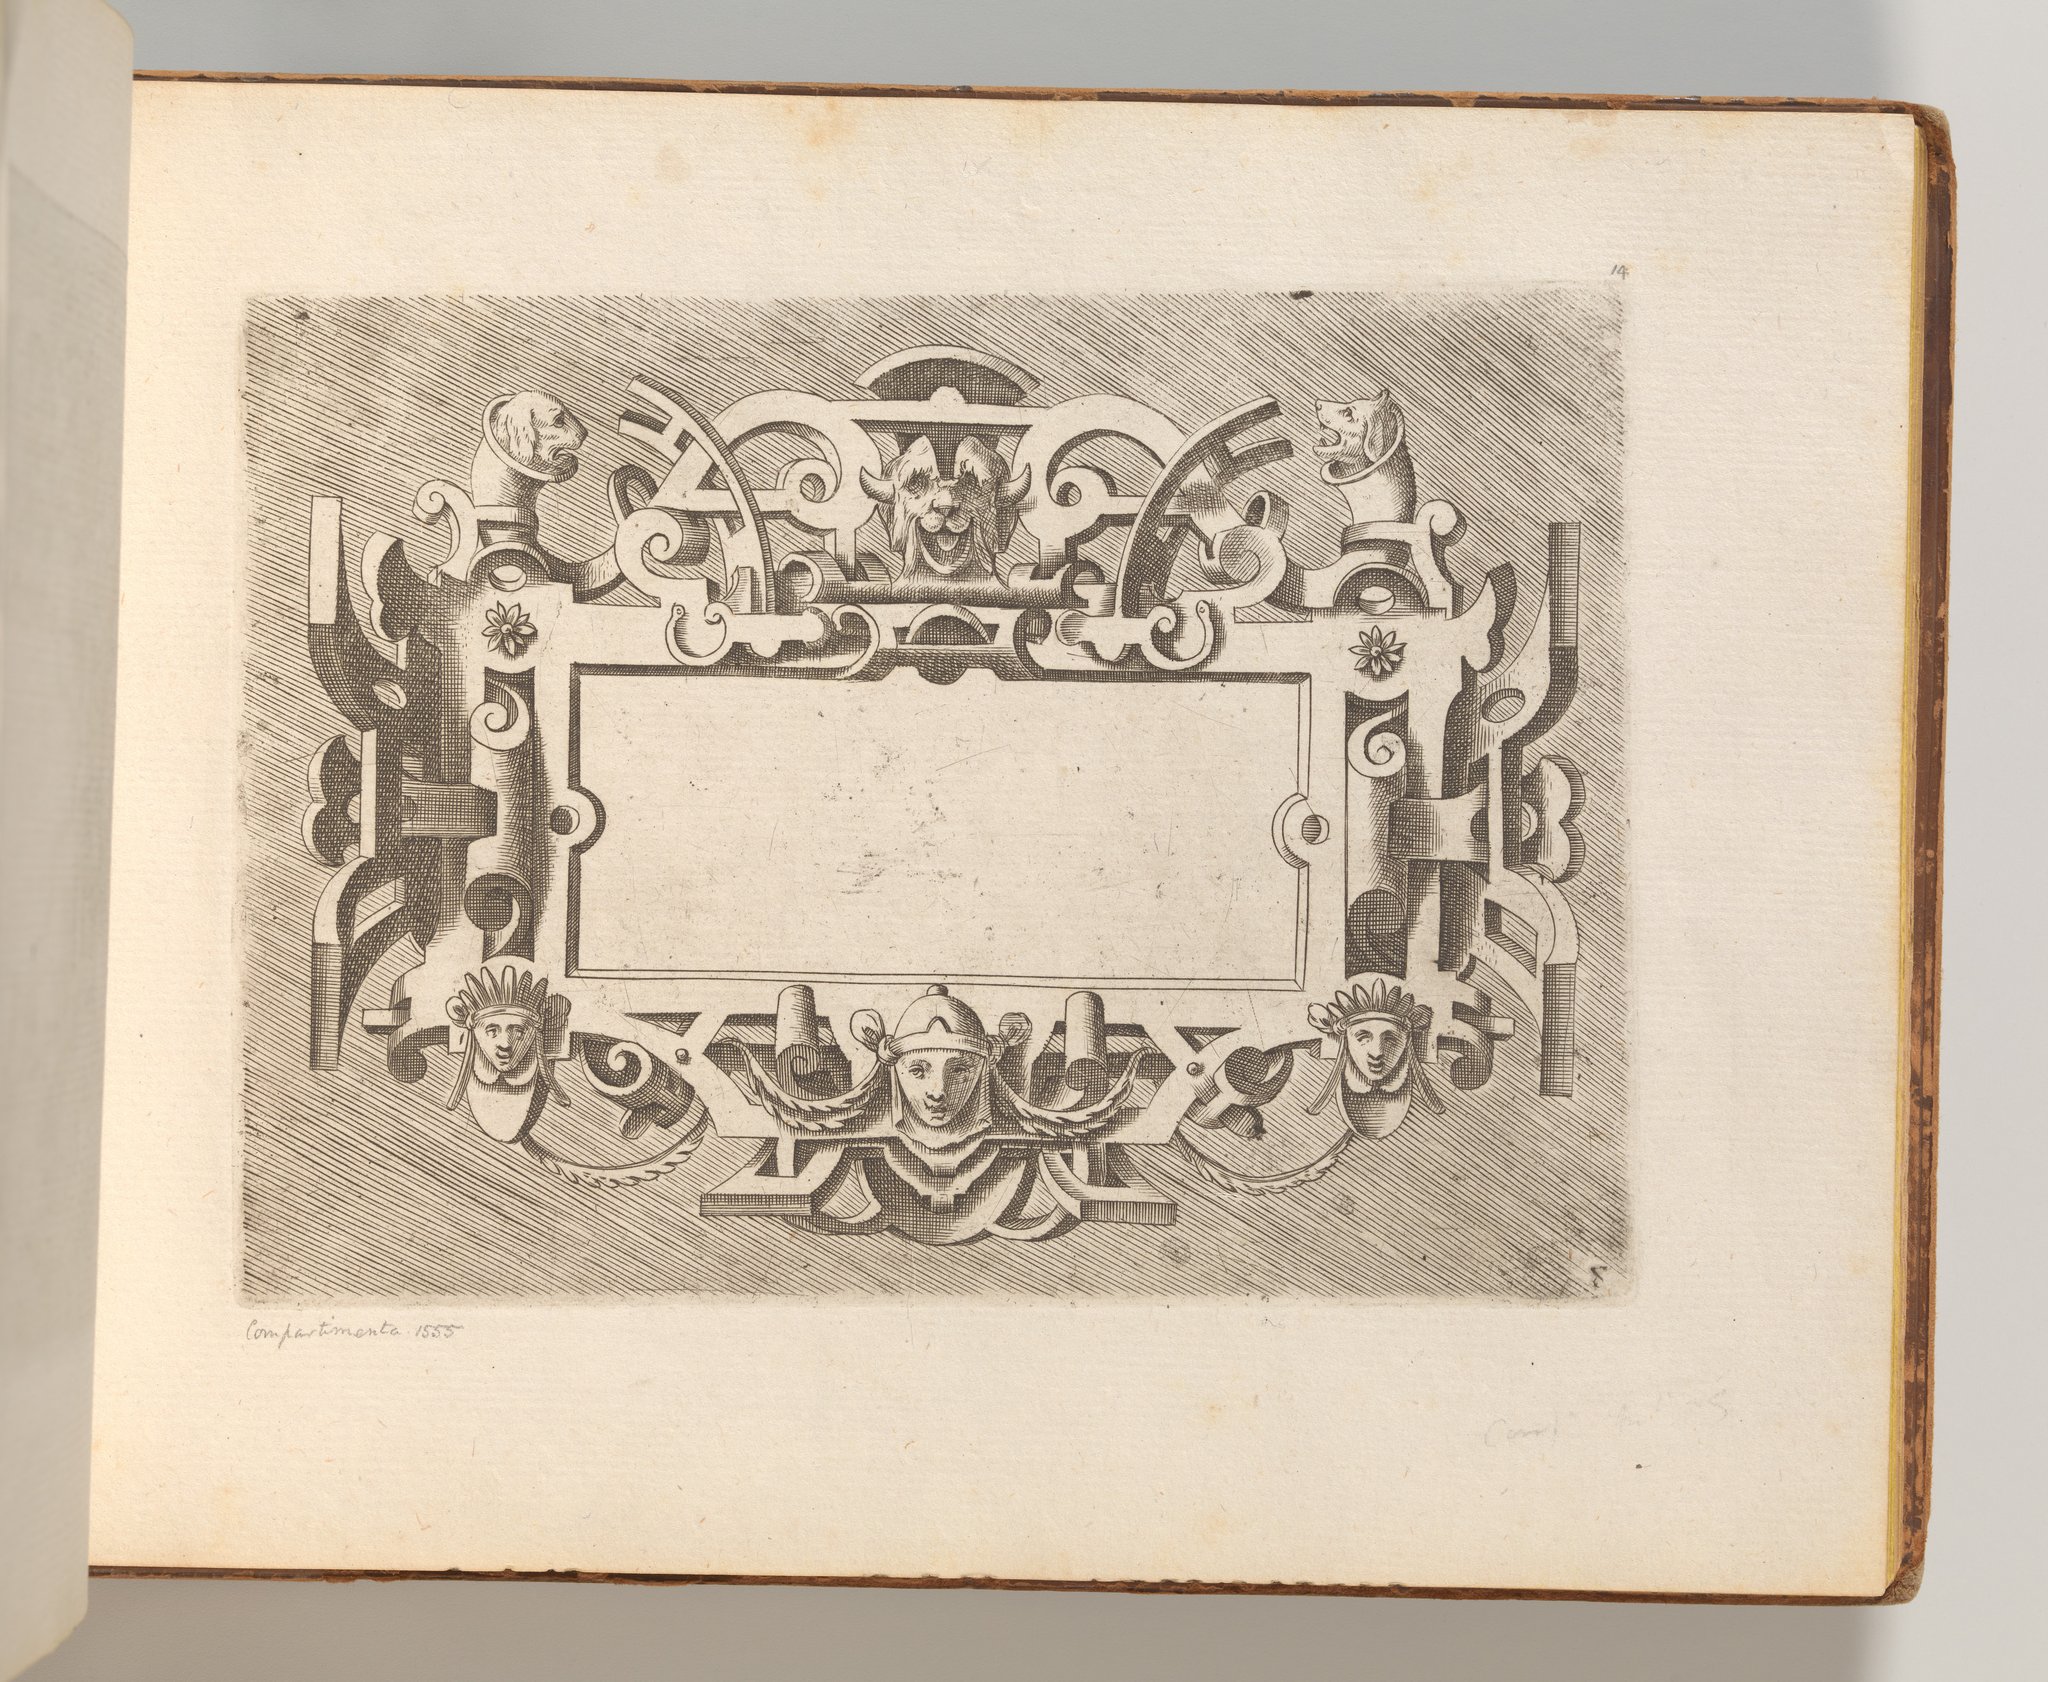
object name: album print ornament architecture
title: Targhe ed altri ornati di varie e capricciose invenzioni (Cartouches and other ornaments of various and capricious invention, page 14)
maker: hans vredeman de vries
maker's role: artist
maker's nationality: netherlandish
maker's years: 1527-1606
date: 1773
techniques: engraving, etching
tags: cartouches,ornament